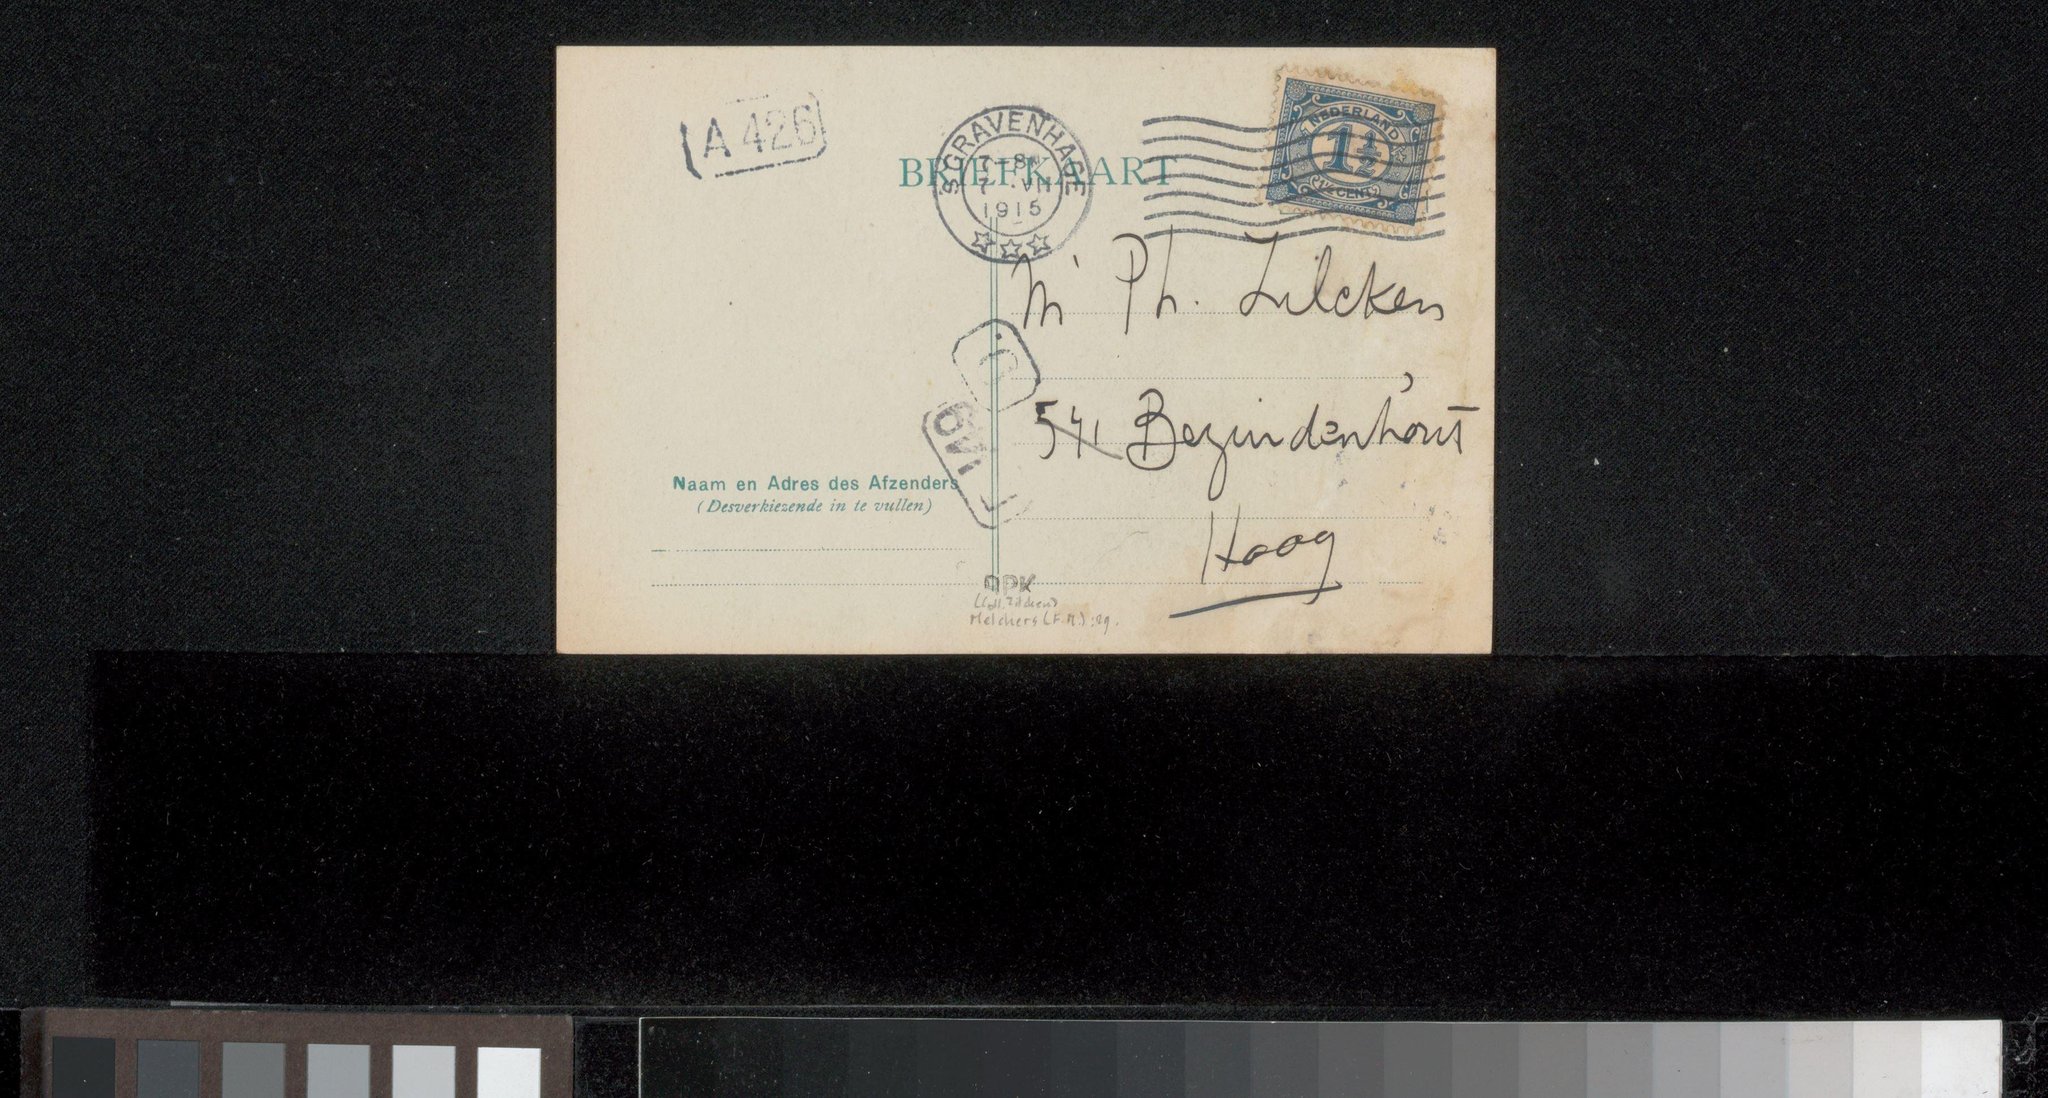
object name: postcard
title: Briefkaart aan Philip Zilcken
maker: franz melchers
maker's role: draughtsman, painter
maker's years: 1868-1944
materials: cardboard, ink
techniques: pen, writing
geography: the hague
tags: the hague, painter, philip zilcken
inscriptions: collector's mark: ‘RPK’